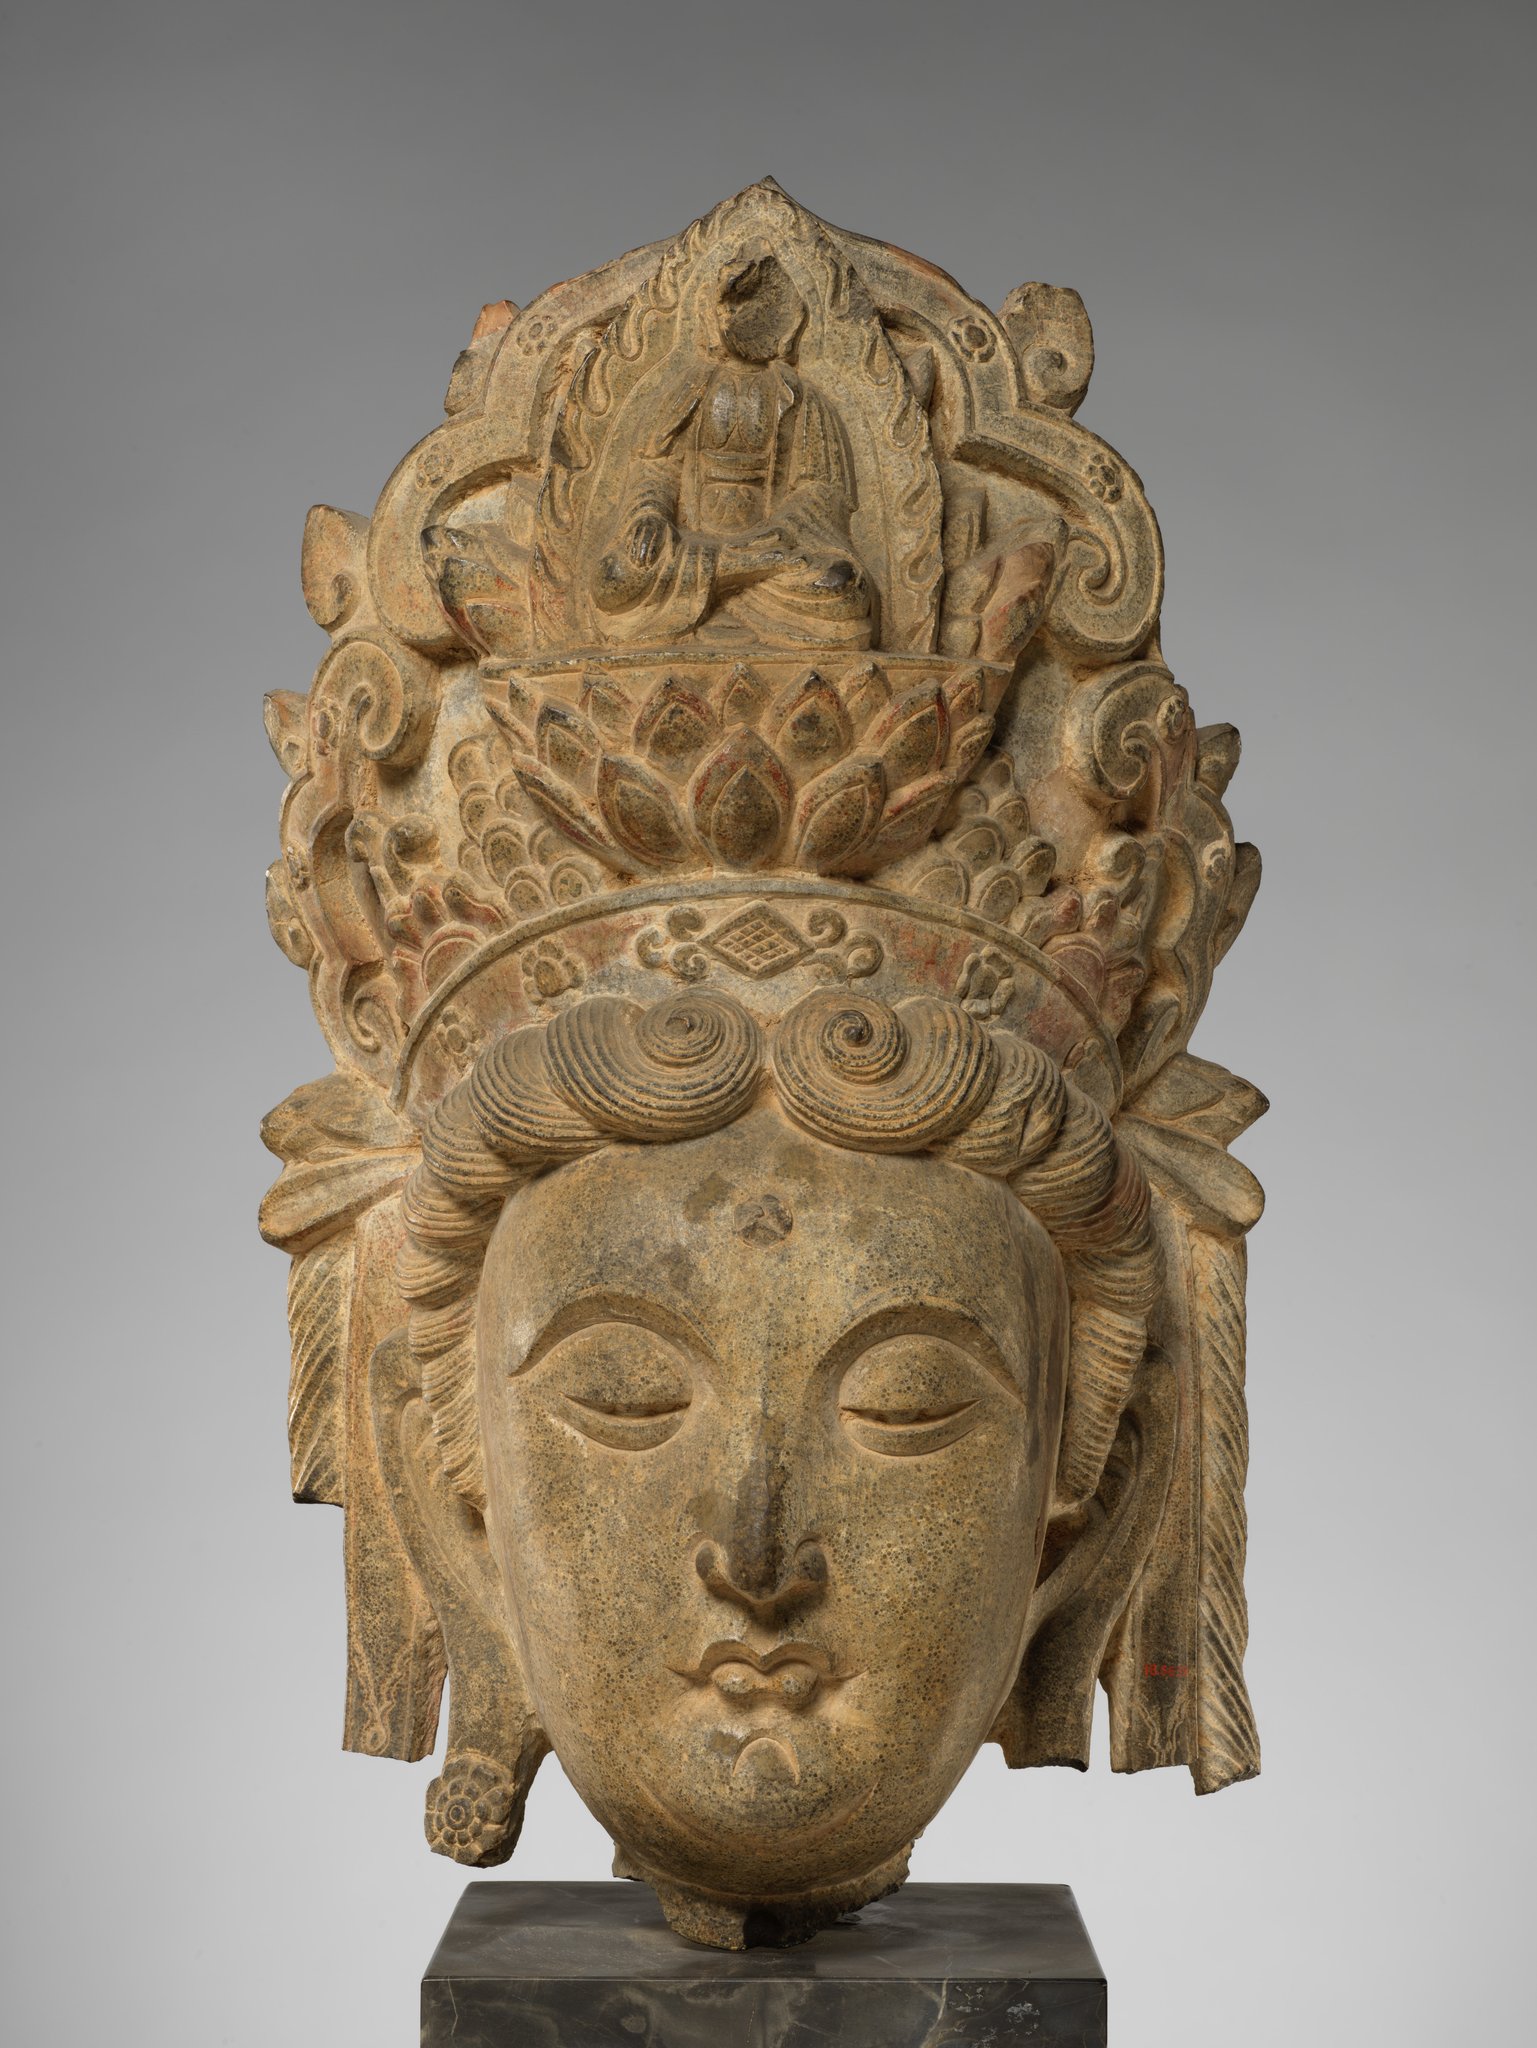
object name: head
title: Head of Guanyin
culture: chinese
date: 1368-1644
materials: stone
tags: heads,bodhisattvas